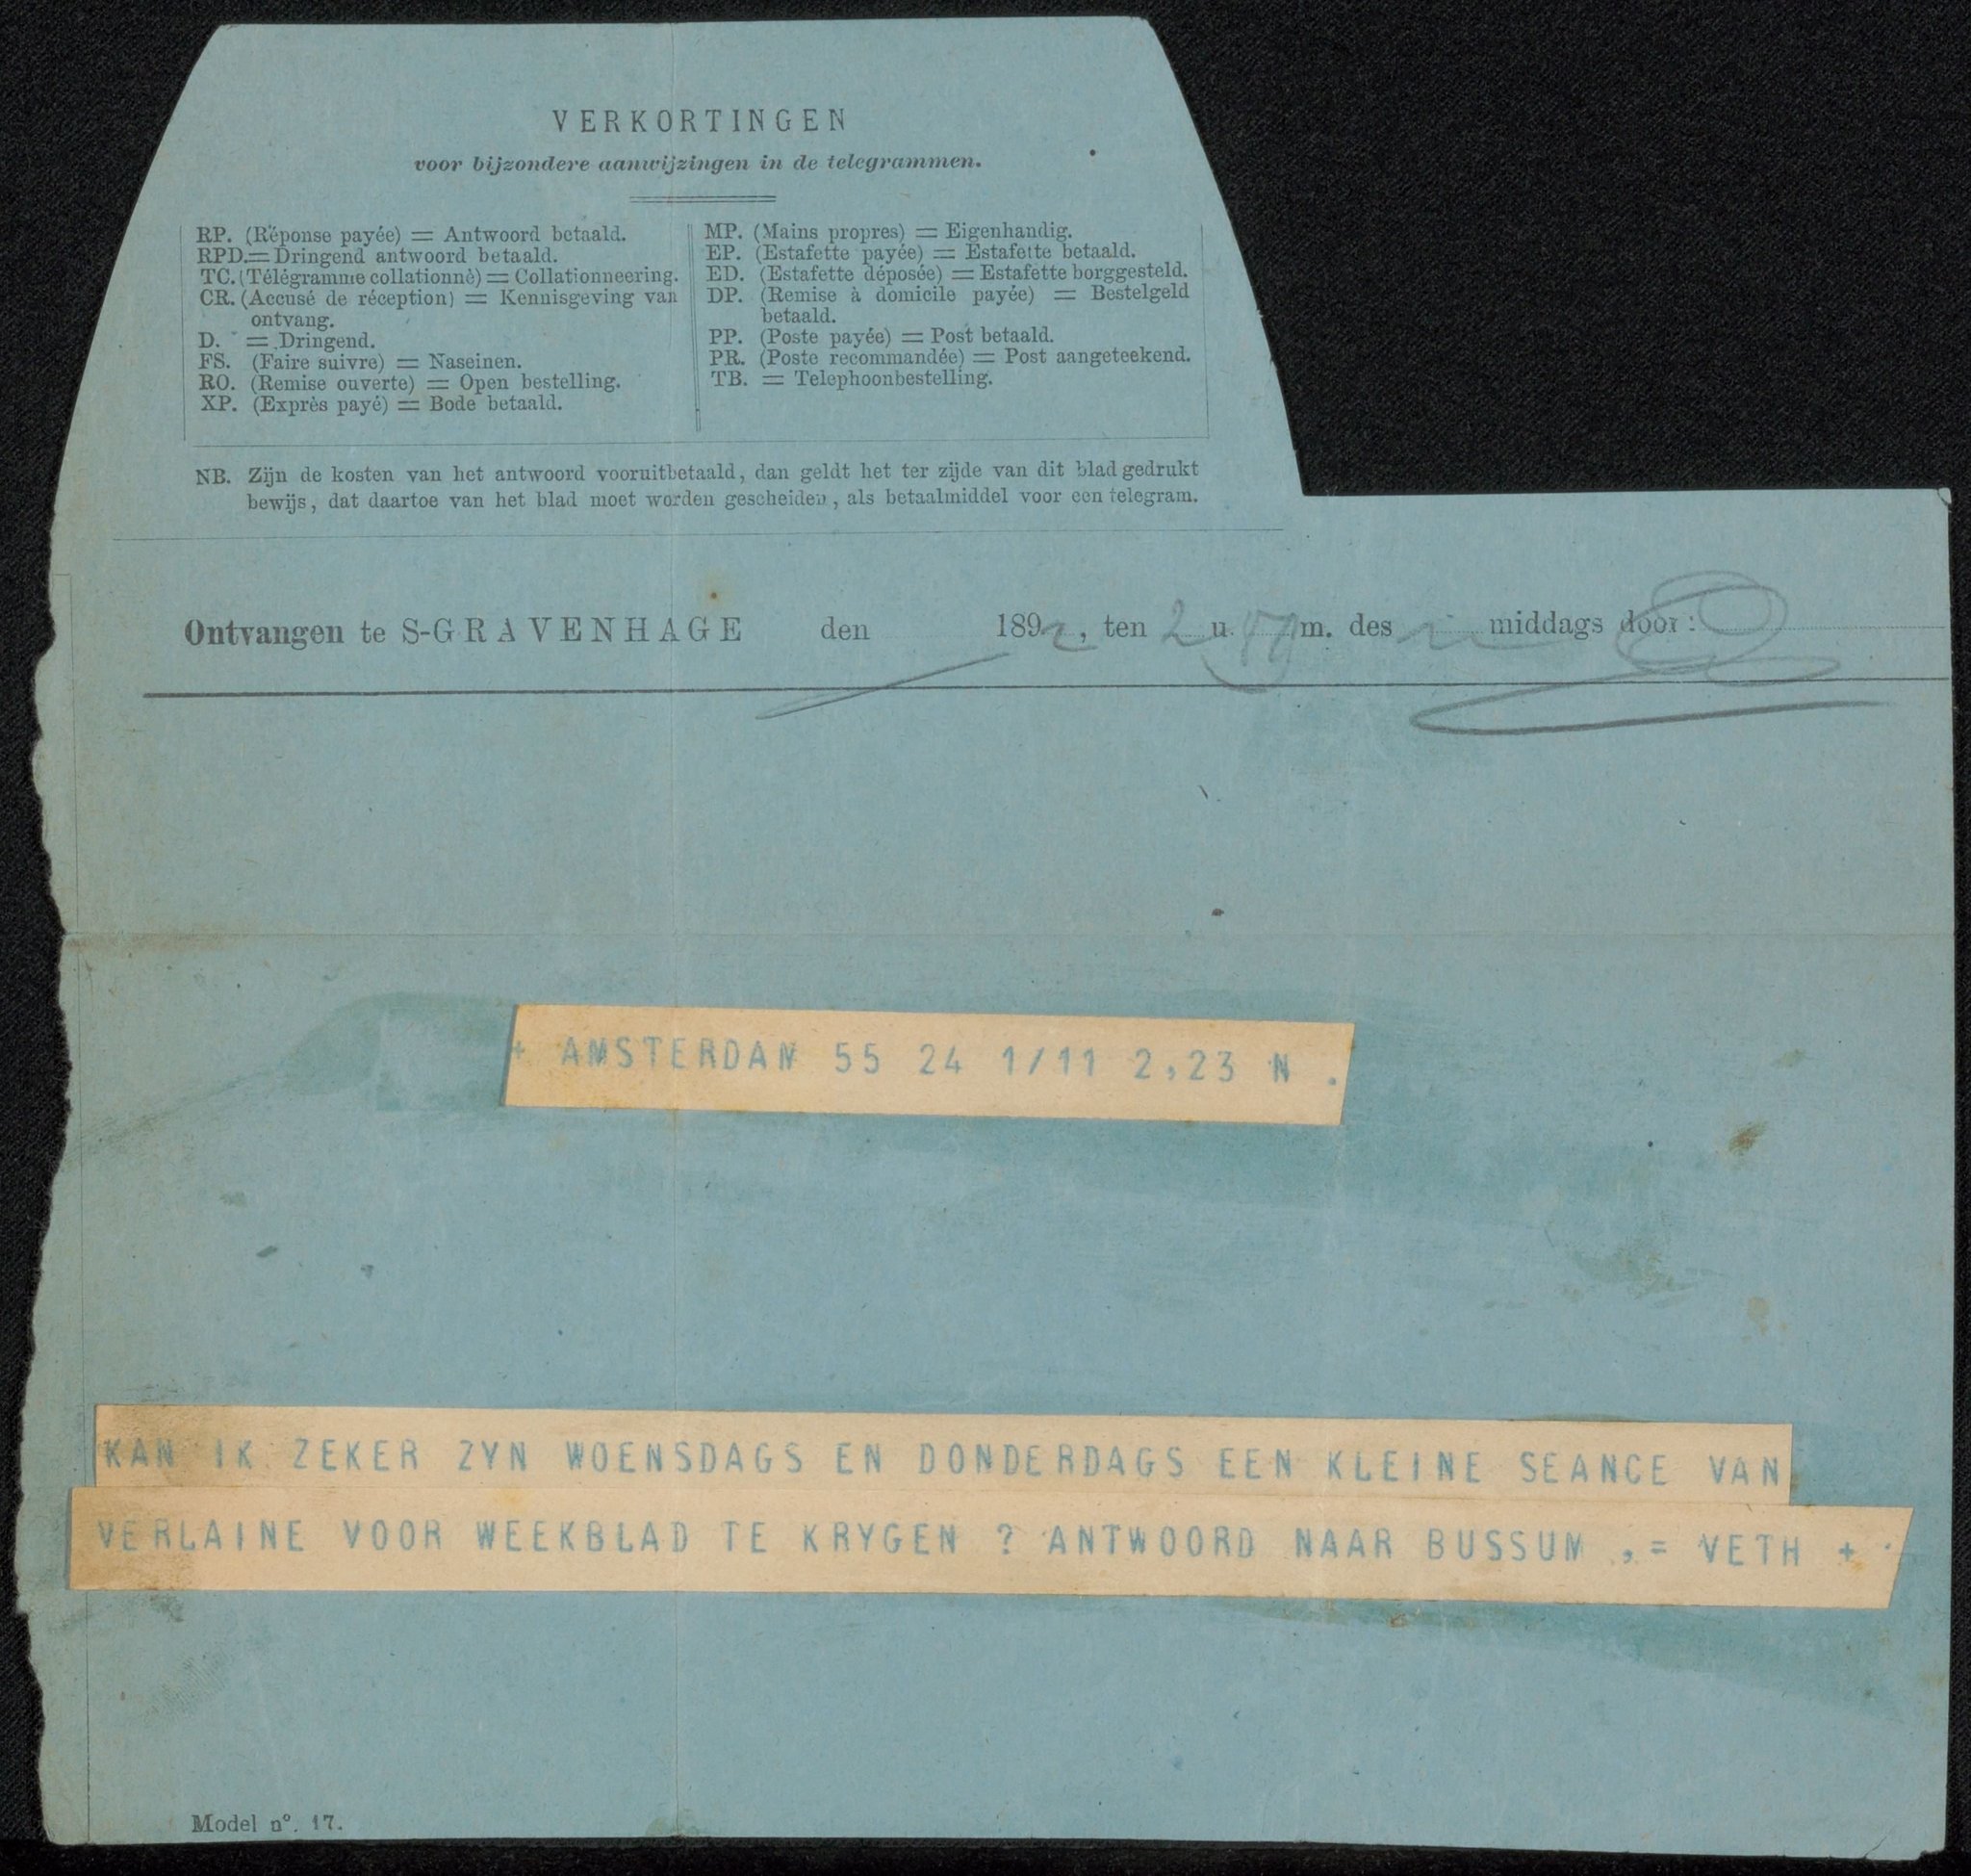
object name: telegram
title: Telegram aan Philip Zilcken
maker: jan veth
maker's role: designer, draughtsman, painter, print maker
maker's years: 1864-1925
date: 1892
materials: paper, pencil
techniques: pen, printing, typewriting, writing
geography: amsterdam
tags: paris, paul verlaine, the hague, painter, draughtsman, philip zilcken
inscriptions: collector's mark: ‘RPK’